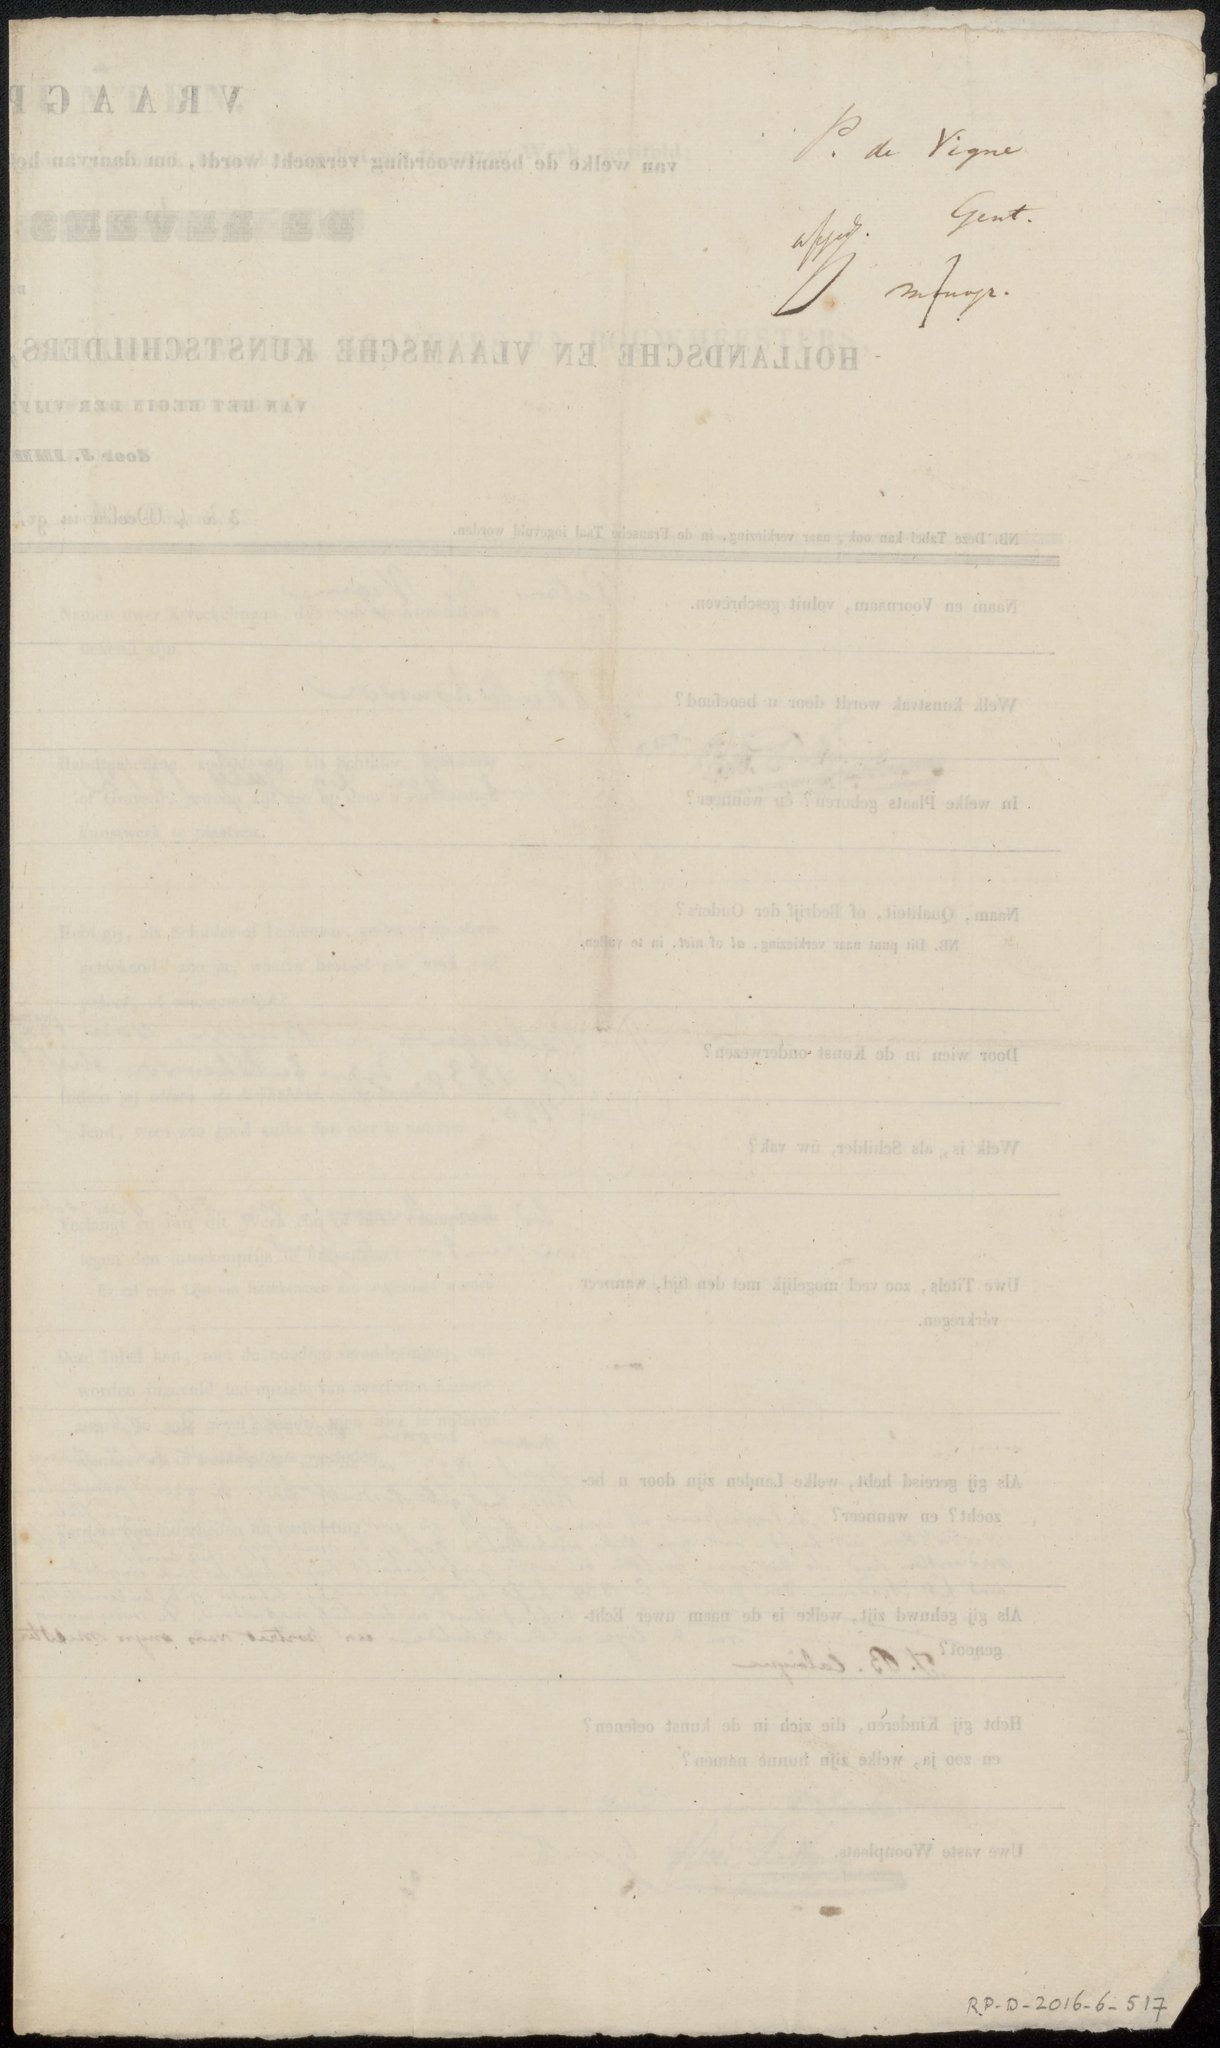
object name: questionnaire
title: Enquêteformulier ingevuld door Petrus De Vigne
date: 1841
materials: ink, paper, pencil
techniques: pen, printing, writing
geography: ghent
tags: draughtsman, petrus de vigne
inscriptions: watermark, inscription: ‘Vraagpunten,/ van welke de beantwoording verzocht wordt, om daarvan het noodig gebruik te maken in het uit te geven Werk, getiteld: De levens en werken/ der Hollandsche en Vlaamsche kunstschilders, beeldhouwers,/ graveurs en bouwmeesters, van het begin der vijftiende eeuw tot heden/ door J. Immerzeel, Jr.’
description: Opgenomen in: Immerzeel, J. Jr., De levens en werken der Hollandsche en Vlaamsche kunstschilders, beeldhouwers, graveurs en bouwmeesters, van het begin der vijftiende eeuw tot heden, Amsterdam: J.C. van Kesteren, 1842-1843.